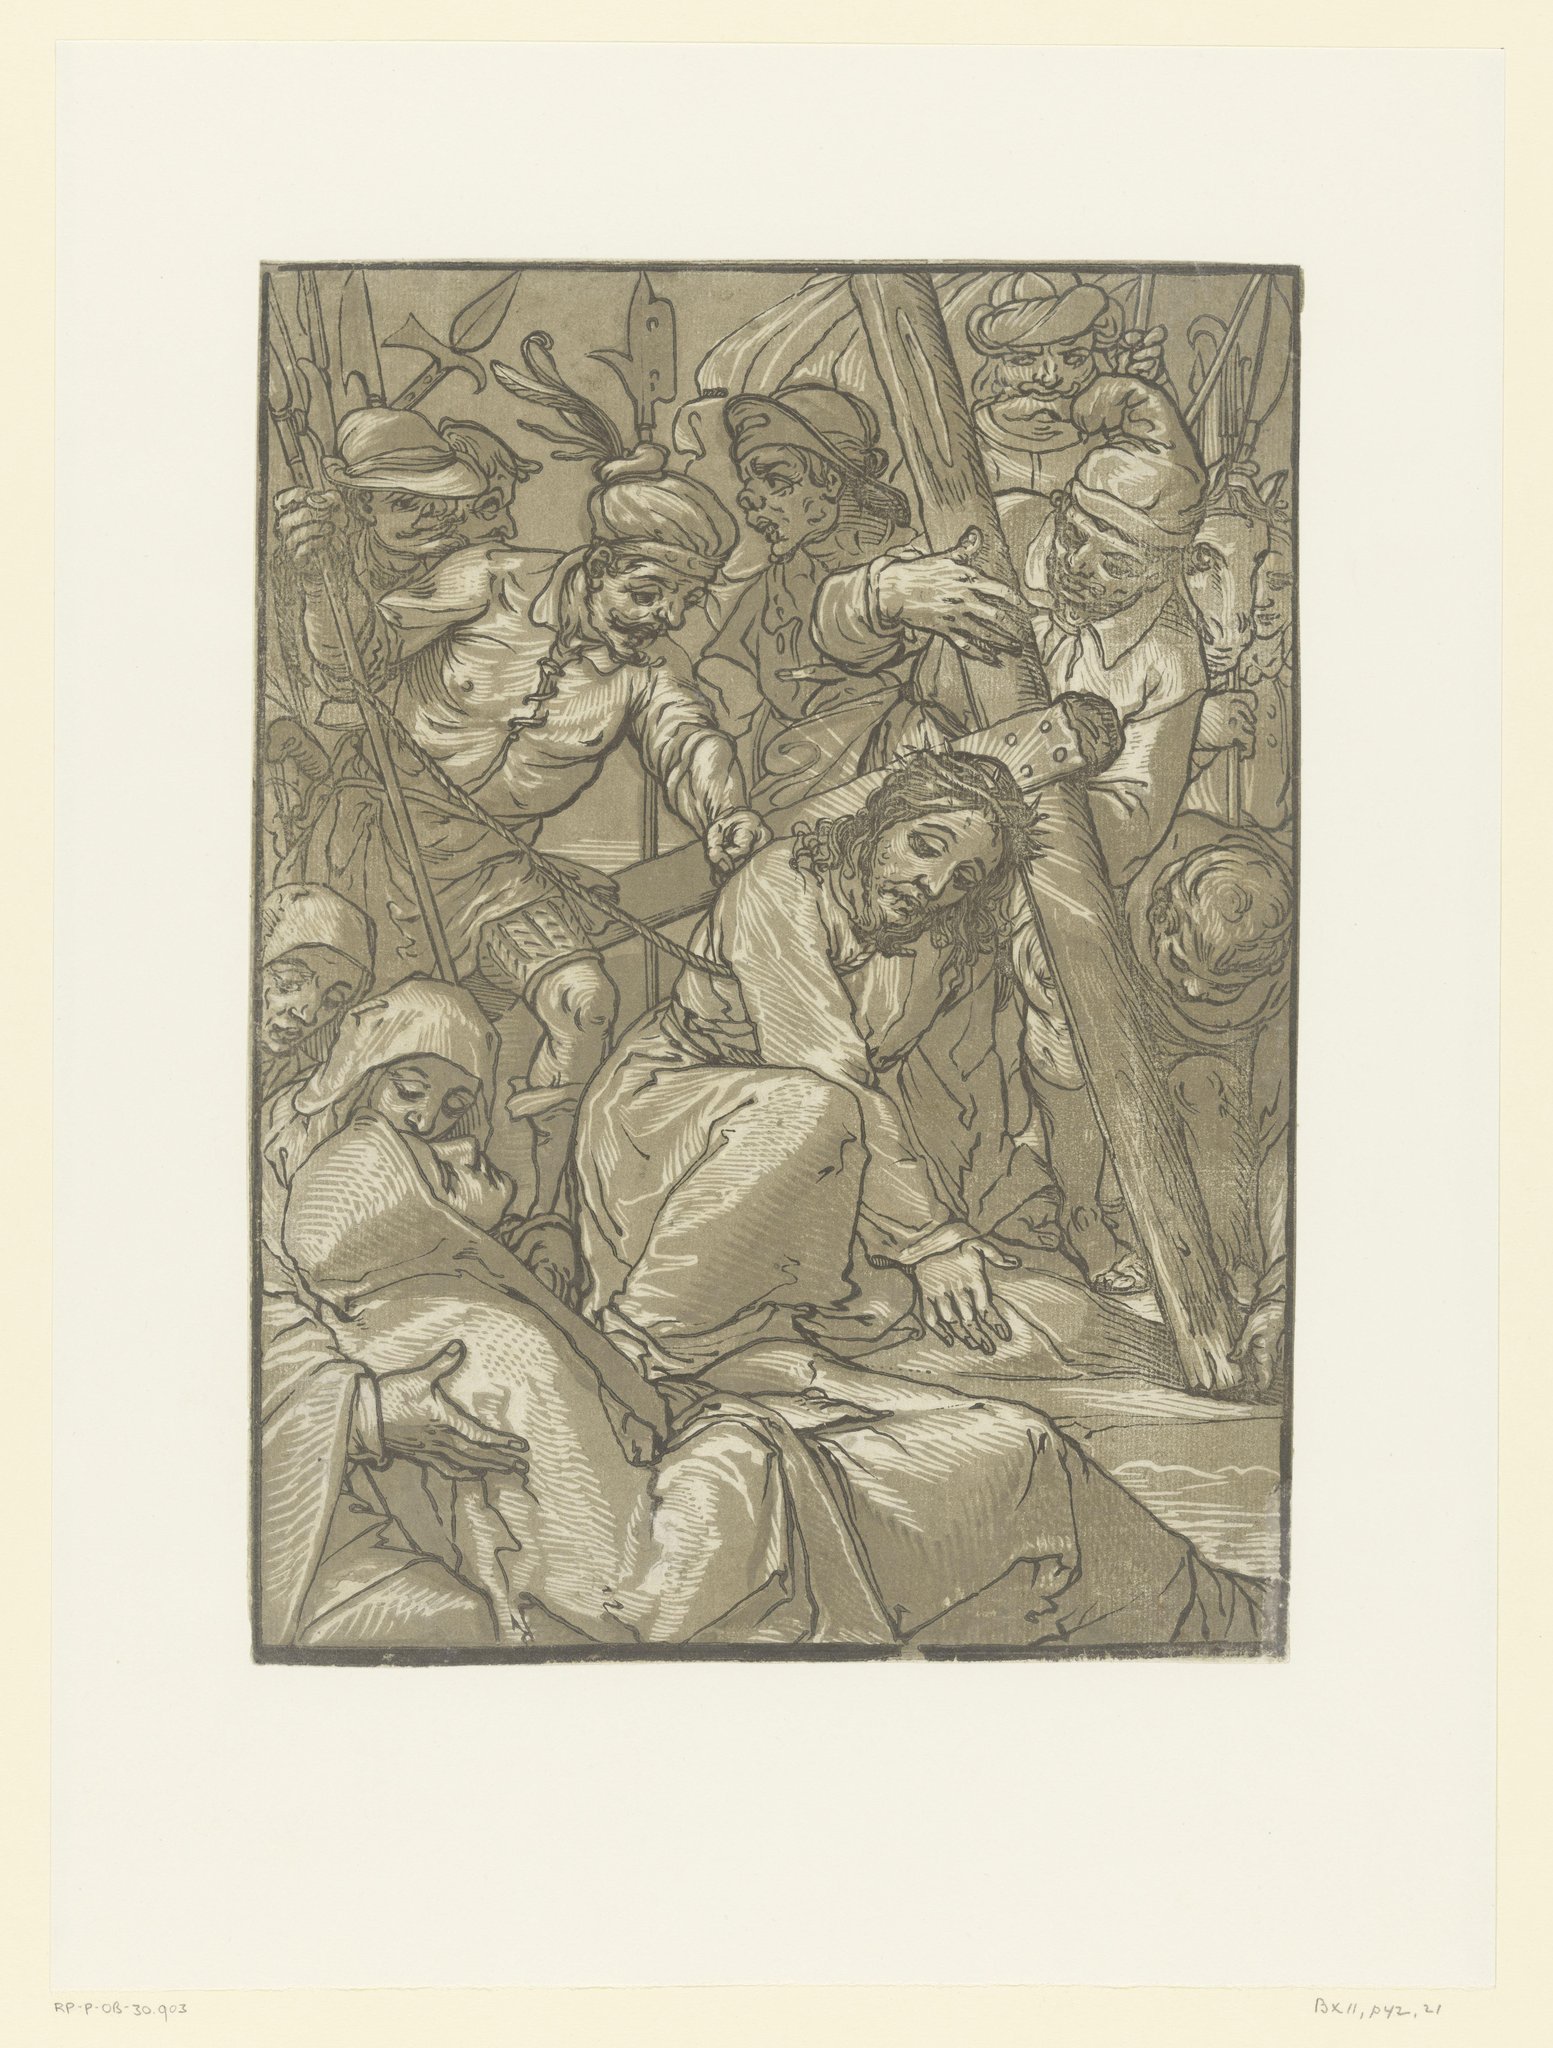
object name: print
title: Kruisdraging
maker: andrea andreani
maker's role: print maker, printer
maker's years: 1558-1629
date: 1591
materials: paper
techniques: woodcut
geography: italy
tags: christ meets mary, who sometimes swoons ('lo spasimo') ~ christ carrying the cross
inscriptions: collector's mark: Lugt 240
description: Christus bezwijkt onder het gewicht van het kruis. Link op de voorgrond de bezwijmende Maria.